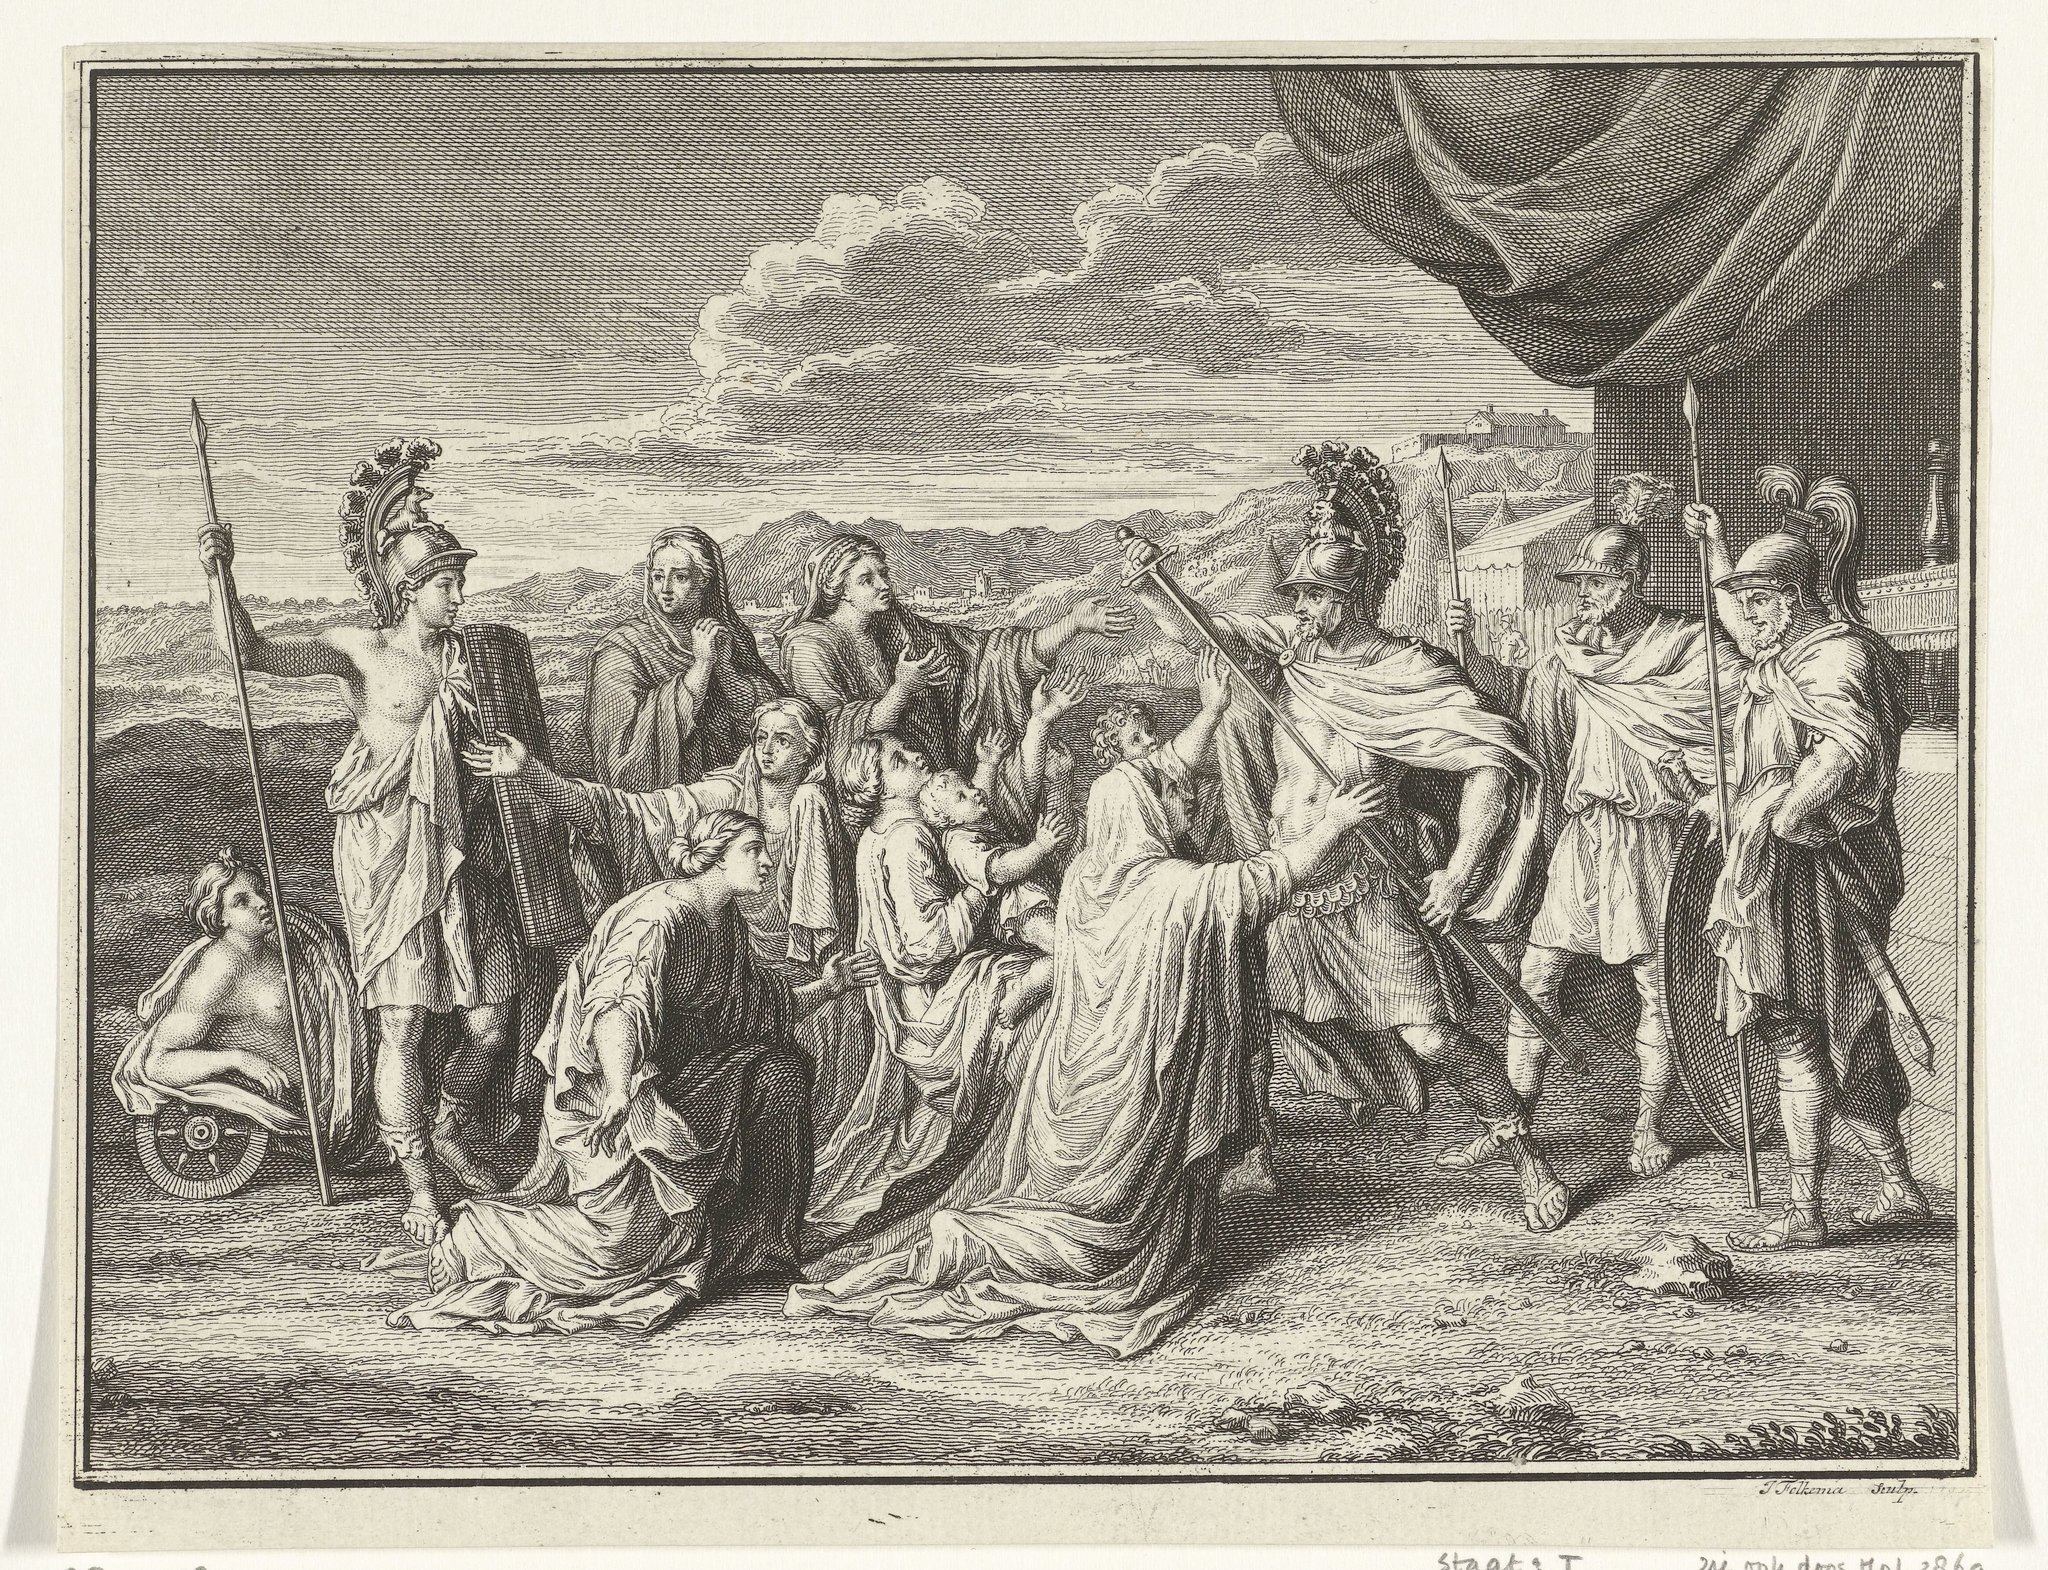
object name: book illustration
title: Coriolanus omringd door smekende vrouwen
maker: jacob folkema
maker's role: draughtsman, print maker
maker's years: 1692-1767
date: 1720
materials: paper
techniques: etching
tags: coriolanus (c. or cn. marcius) is met by his wife volumnia (alternatively called vergilia) with their two small sons, and his mother veturia (alternatively called volumnia); they entreat him not to fight any more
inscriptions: collector's mark: Lugt 240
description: Coriolanus trekt zijn zwaard en wordt omringd door zijn geknielde moeder, echtgenote en andere vrouwen die hem smeken Rome niet aan te vallen.